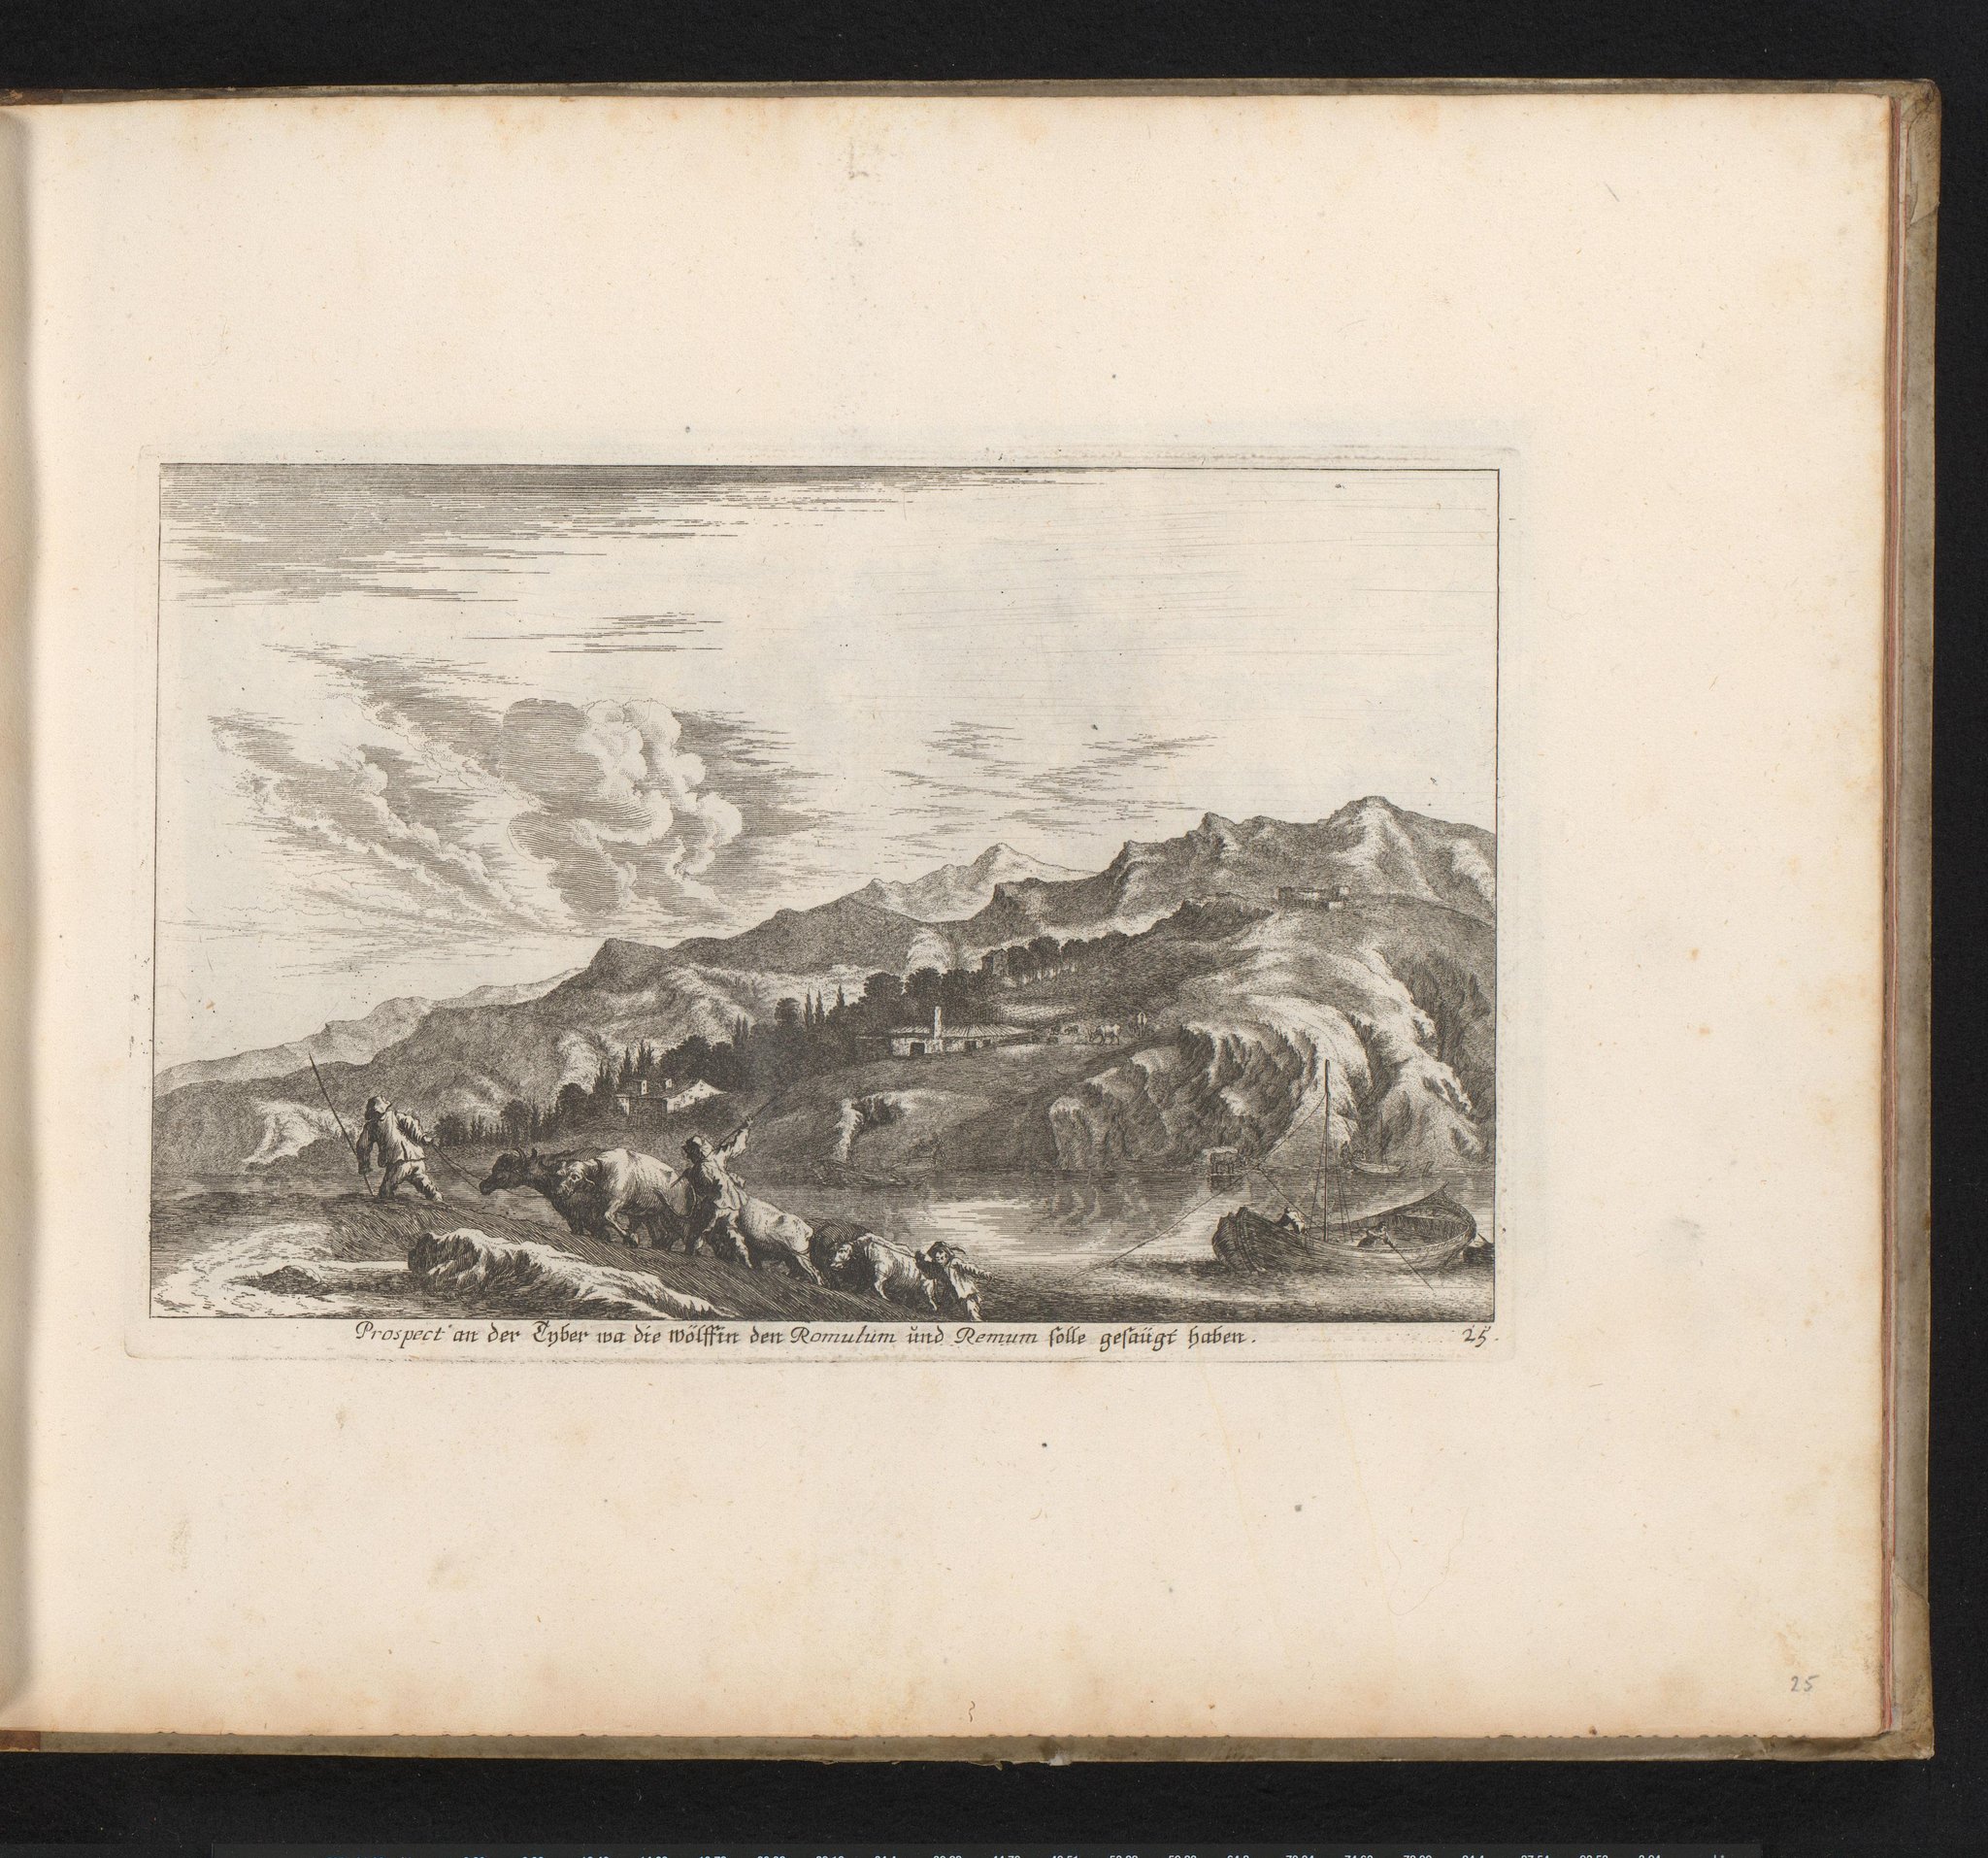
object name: album leaf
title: Gezicht op heuvels bij Rome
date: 1670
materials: paper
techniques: etching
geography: augsburg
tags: romulus and remus are washed ashore and suckled by a she-wolf; 'lupa romana', harbour (+ departure and arrival ~ traffic and transport), ship bound for the harbour (+ zoological aspects of animals in traffic and transport), rome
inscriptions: collector's mark: Lugt 2228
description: Tekst in het Duits in de ondermarge. Rechtsonder genummerd: 25. Prent maakt deel uit van een album.